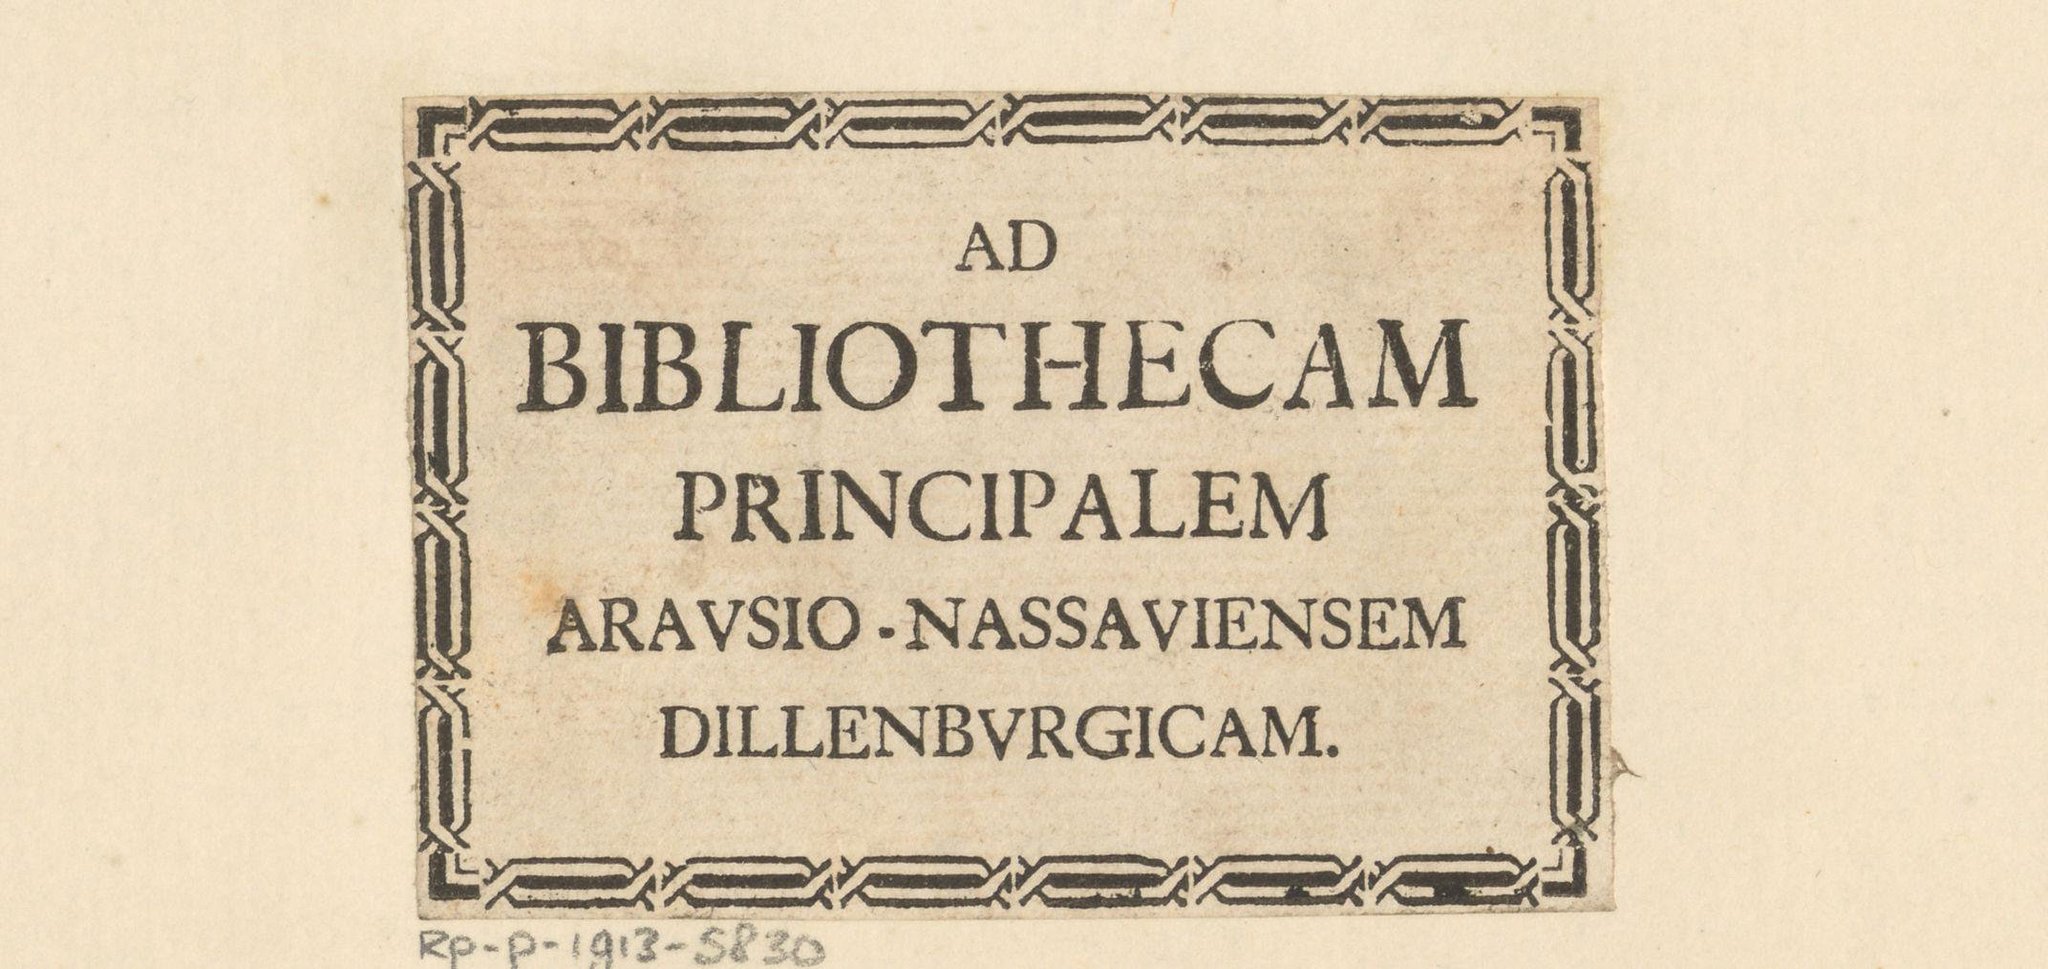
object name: bookplate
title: Ex libris van Bibliothecam Principalem Arauiso-Nassauiensem Dillenburgicam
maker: Anonymous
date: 1700-1799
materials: paper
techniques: letterpress printing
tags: dillenburg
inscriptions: collector's mark: Lugt 2233